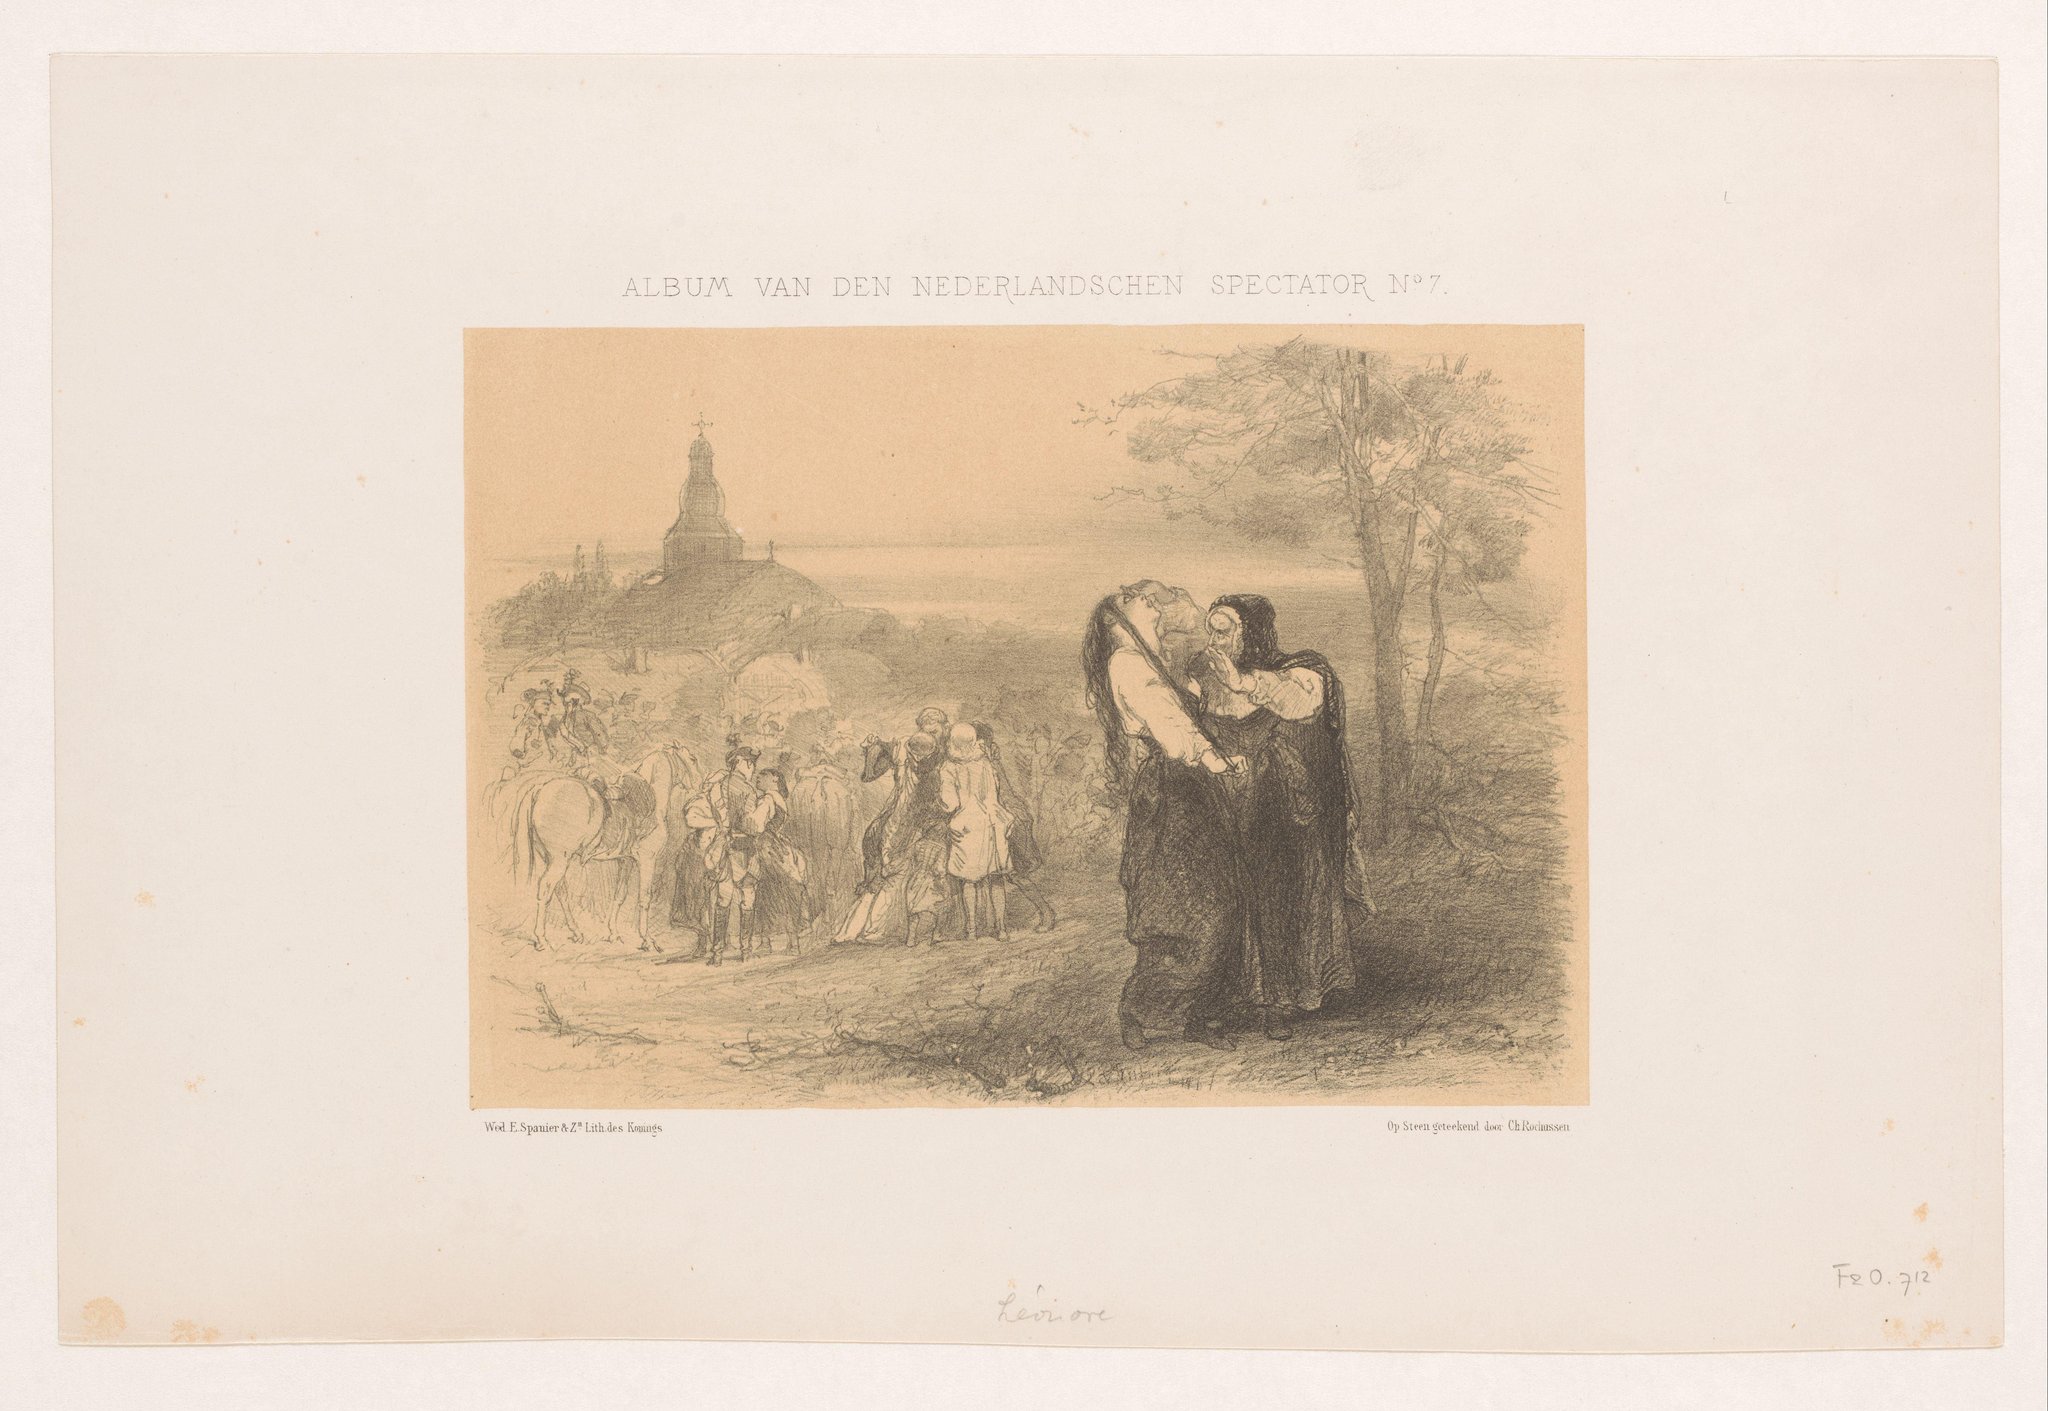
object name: print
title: Leonoor in wanhoop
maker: charles rochussen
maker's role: draughtsman, painter, print maker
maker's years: 1814-1894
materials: paper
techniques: tone lithography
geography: the hague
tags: despair; 'disperatione' (ripa), return of the soldiers to civilian life, returning home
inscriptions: collector's mark: Lugt 2228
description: Een wanhopige jonge vrouw wordt getroost of gekalmeerd door een oude vrouw. Links teruggekeerde soldaten met hun geliefden en in de achtergrond een kerktoren.